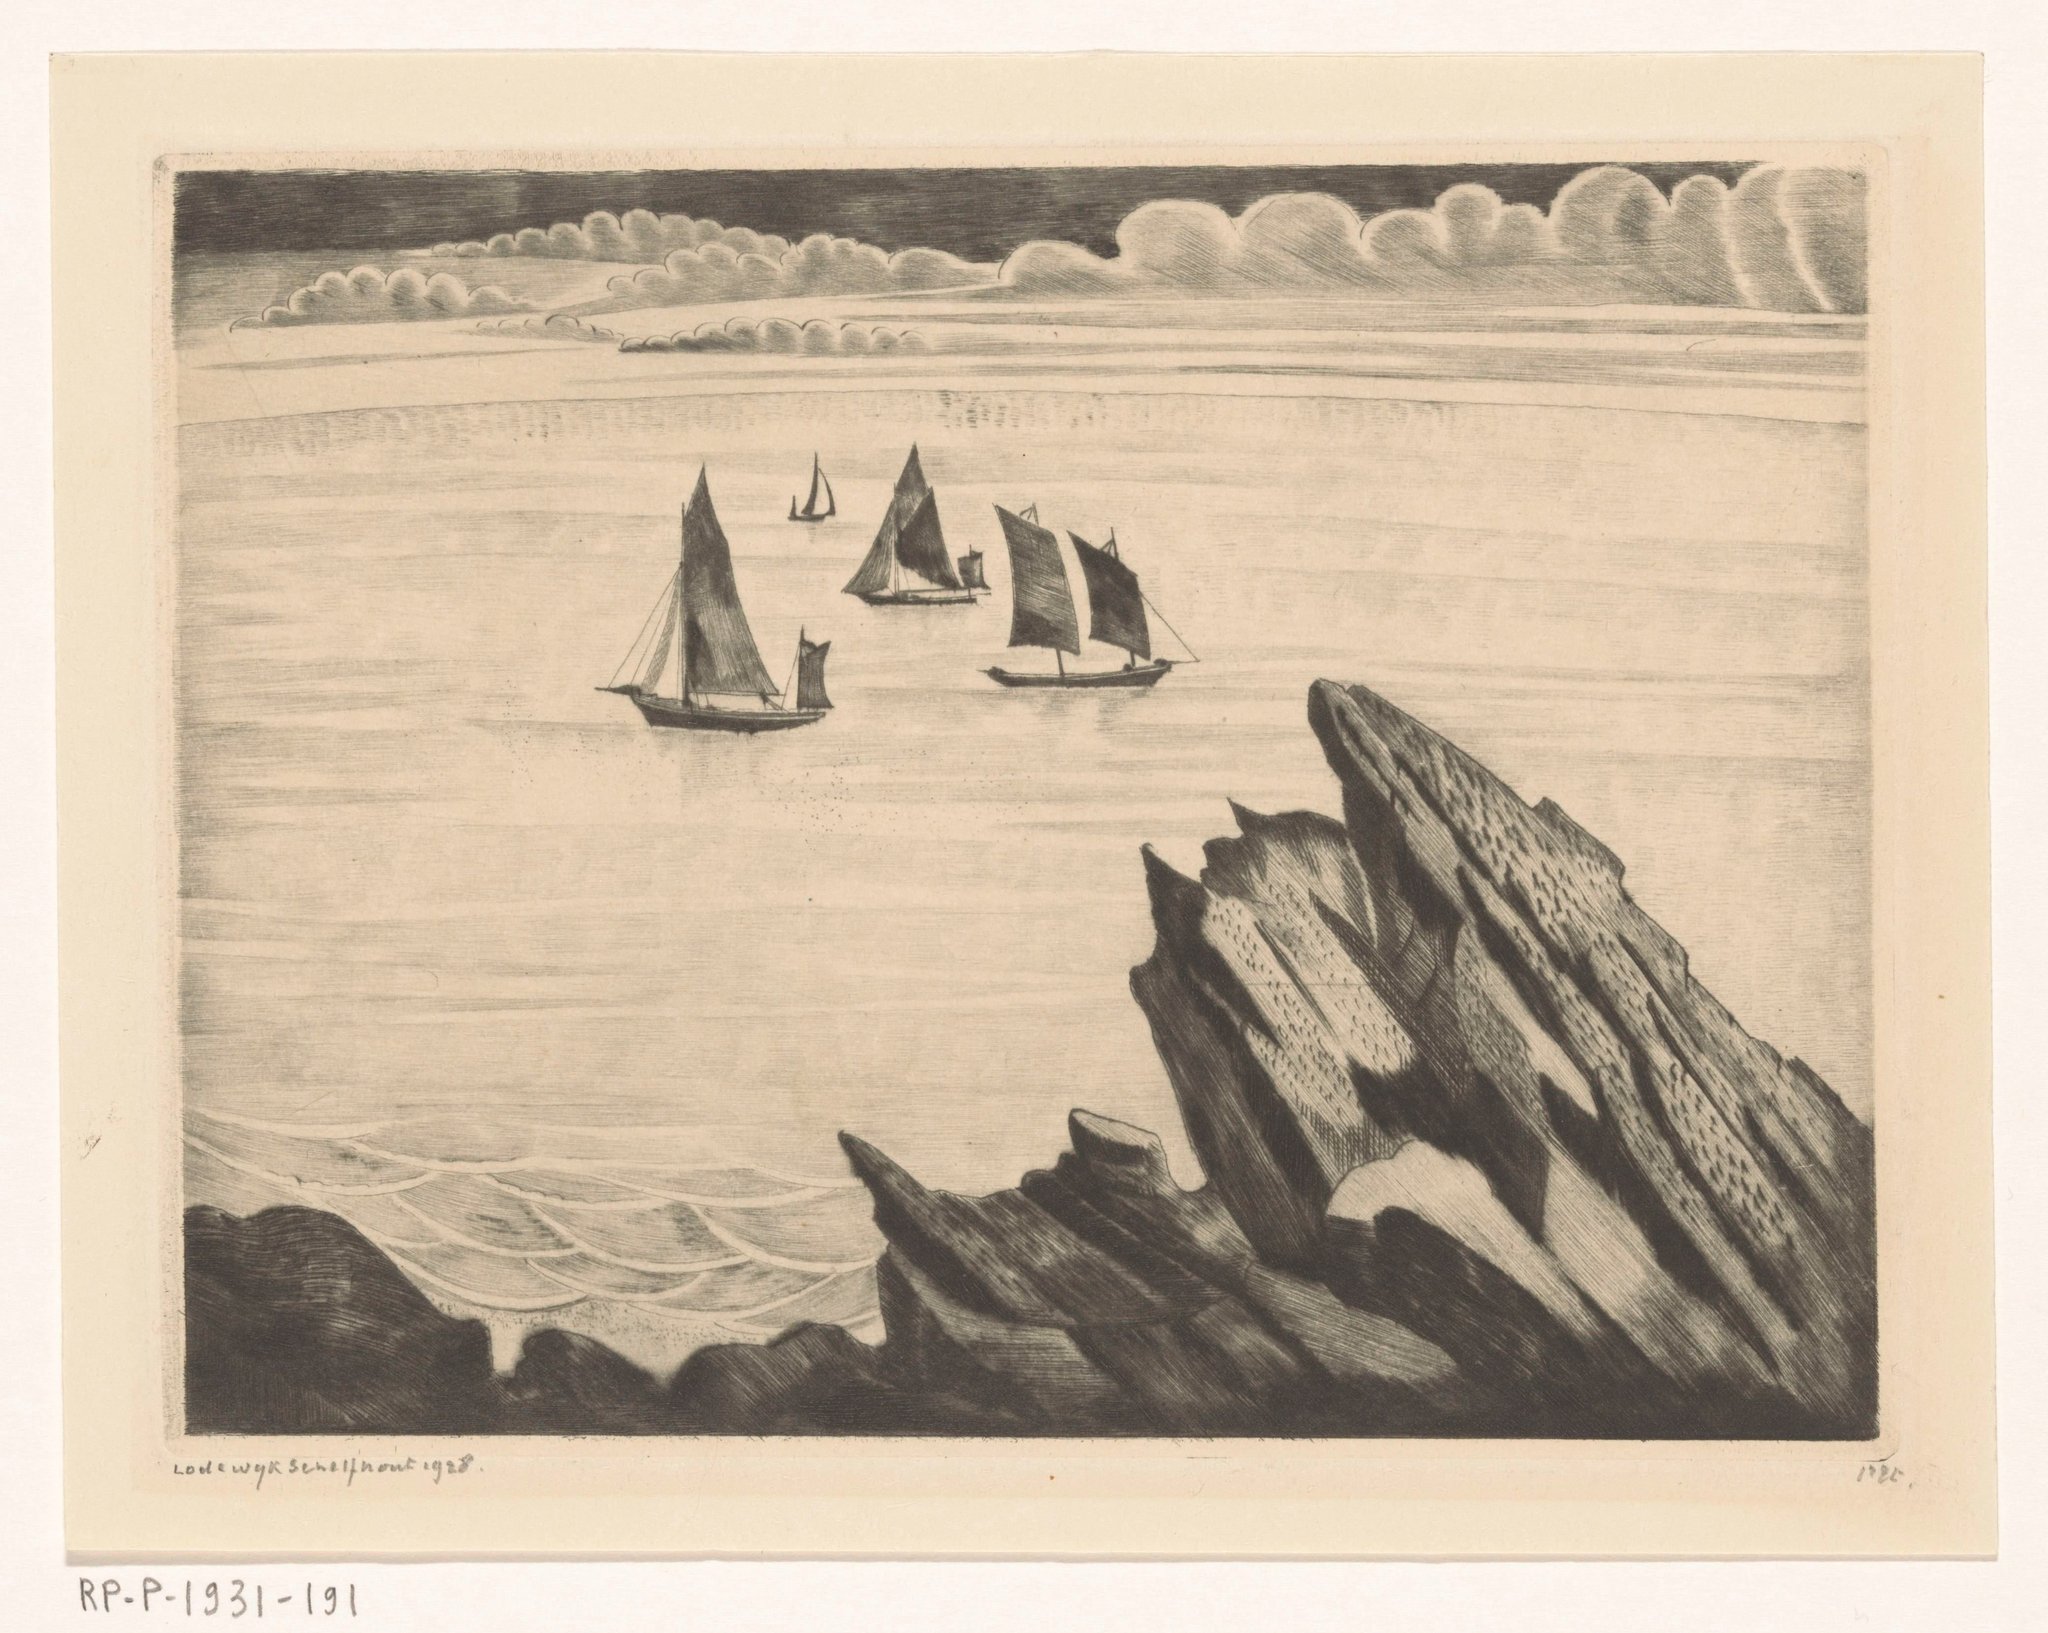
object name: print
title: Un soir en Bretagne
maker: lodewijk schelfhout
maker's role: draughtsman, print maker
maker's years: 1881-1943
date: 1928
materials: paper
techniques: drypoint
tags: sailing-ship, sailing-boat, rocky coast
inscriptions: collector's mark: Lugt 2228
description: Vier zeilschepen langs de kust van Bretagne. Op de voorgrond rotsen.